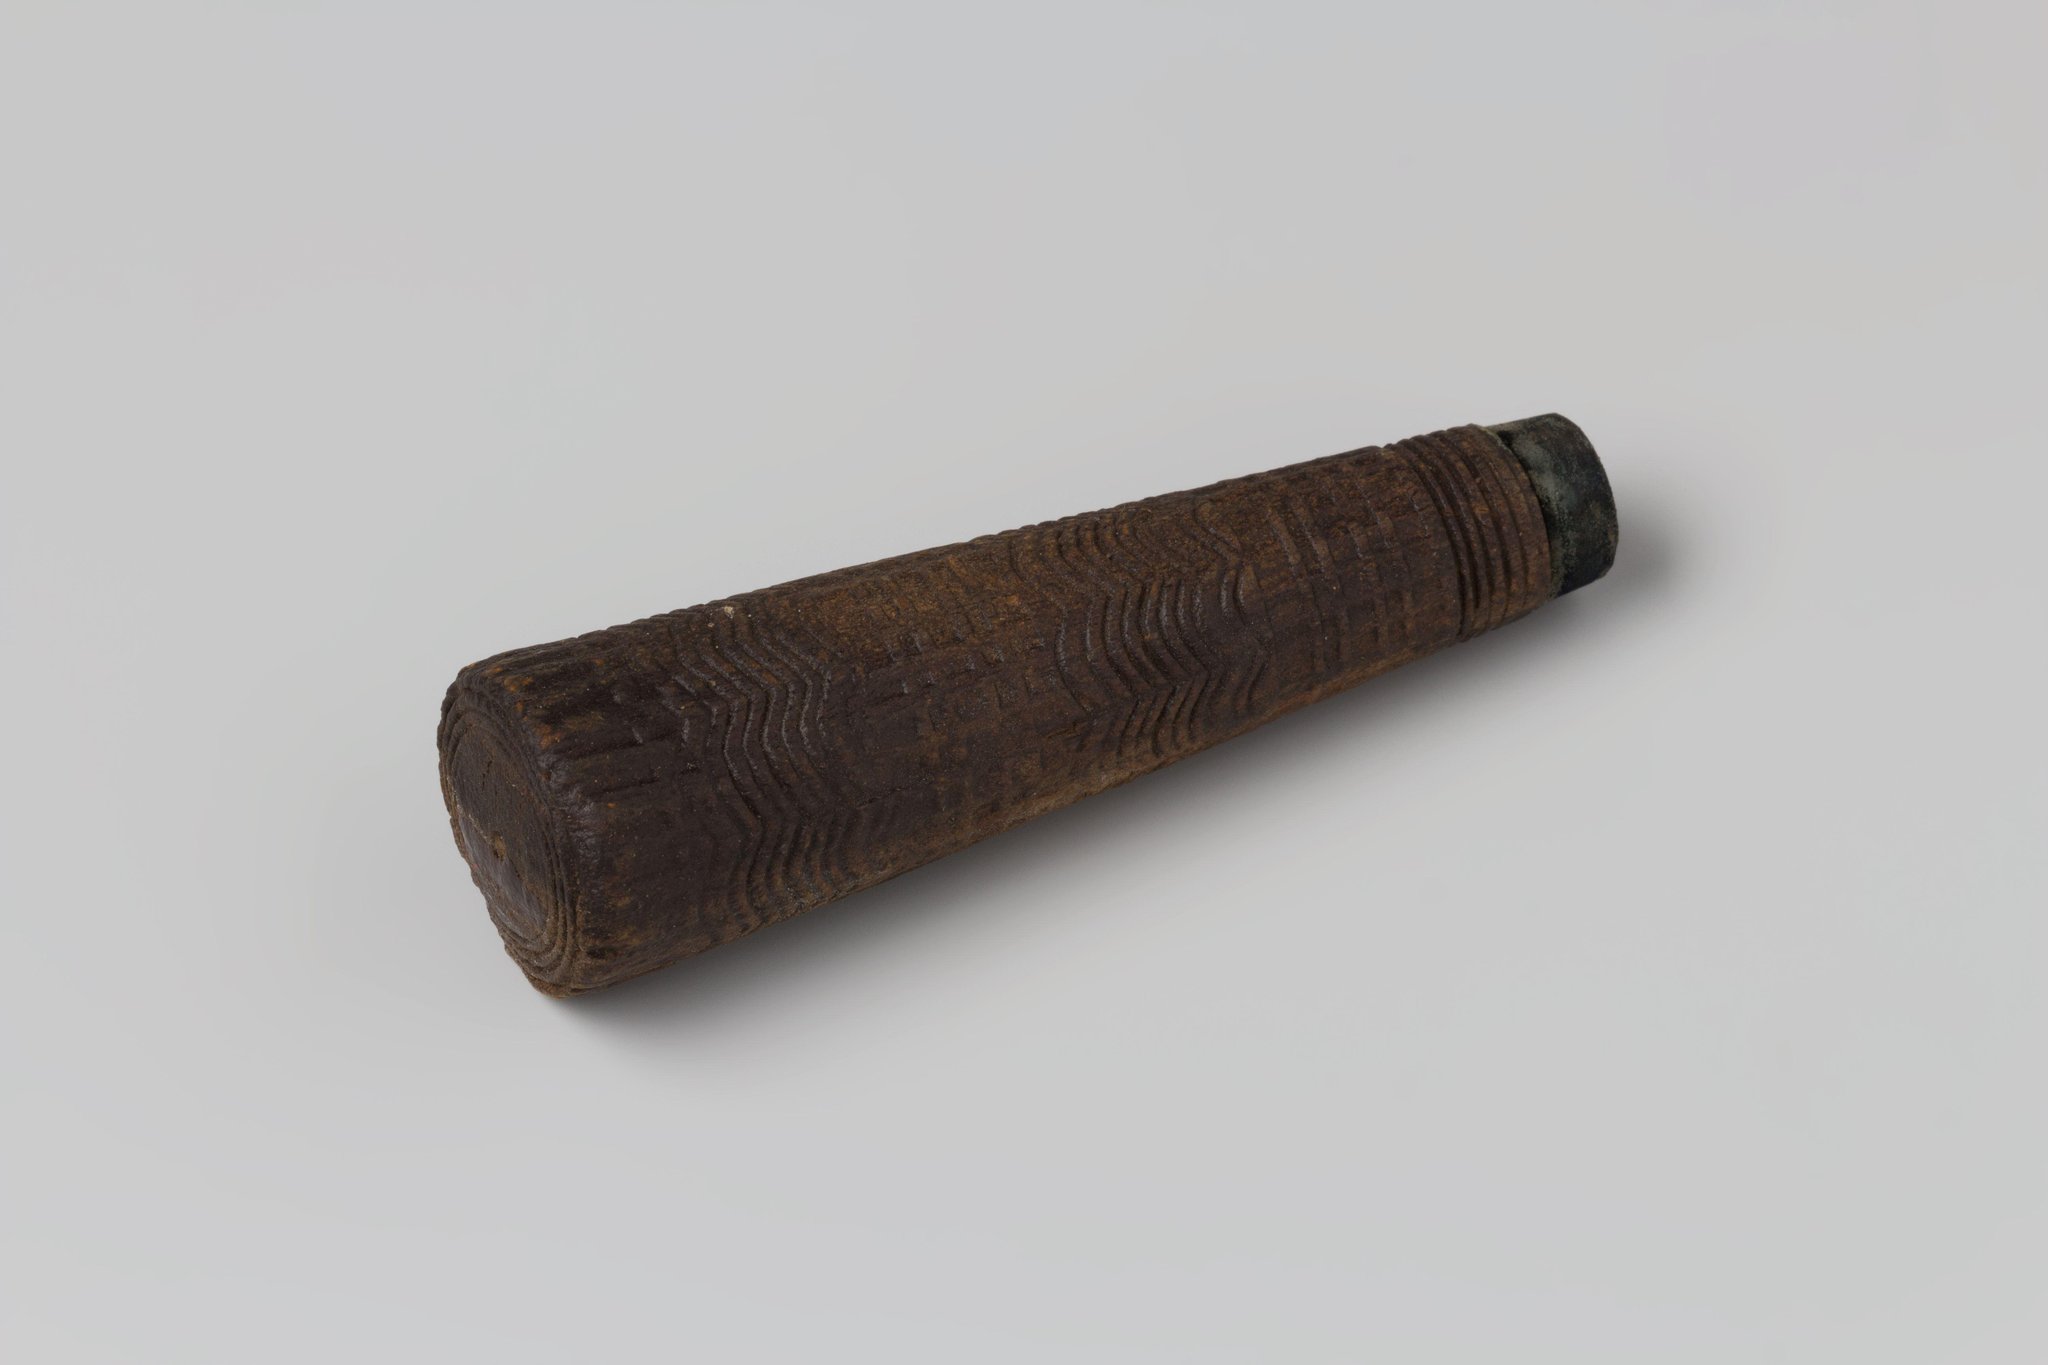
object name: knife handle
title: Messenheft uit het wrak van de Oost-Indiëvaarder Hollandia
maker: Anonymous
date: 1700-1743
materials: copper, wood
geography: netherlands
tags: verenigde oostindische compagnie, hollandia (schip), annet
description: Knife, handle, cylindrical: tapering; id. NG 1979-403H, ferrule, id. NG 1980-27H426.